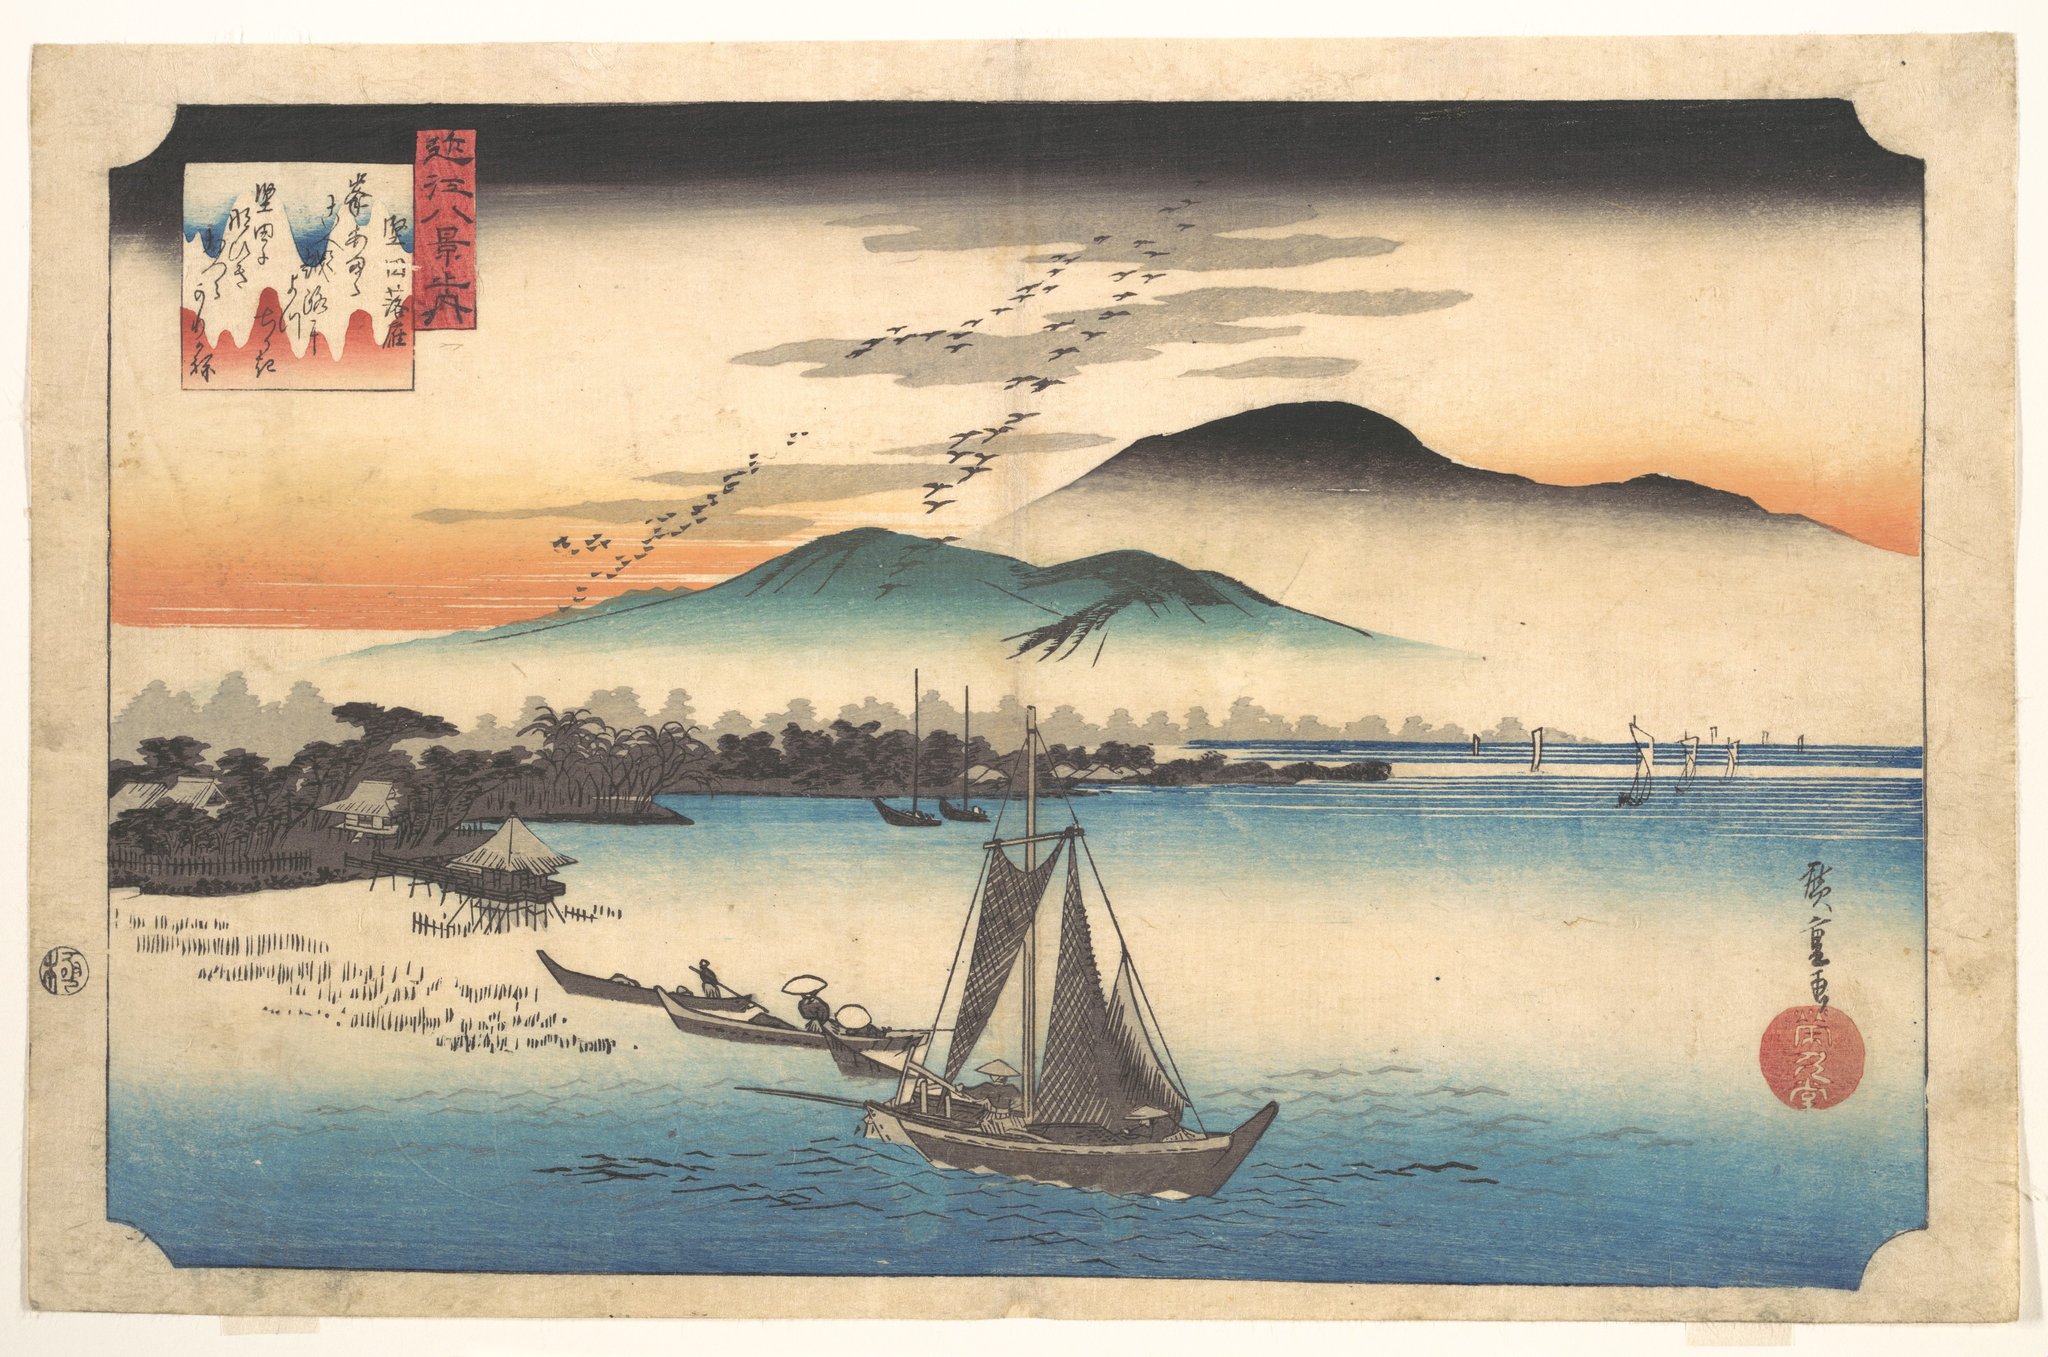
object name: print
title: Returning Geese at Katada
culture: japanese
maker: utagawa hiroshige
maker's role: artist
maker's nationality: japanese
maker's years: 1797-1858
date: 1797-1858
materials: ink, paper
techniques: woodblock print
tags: lakes,mountains,boats